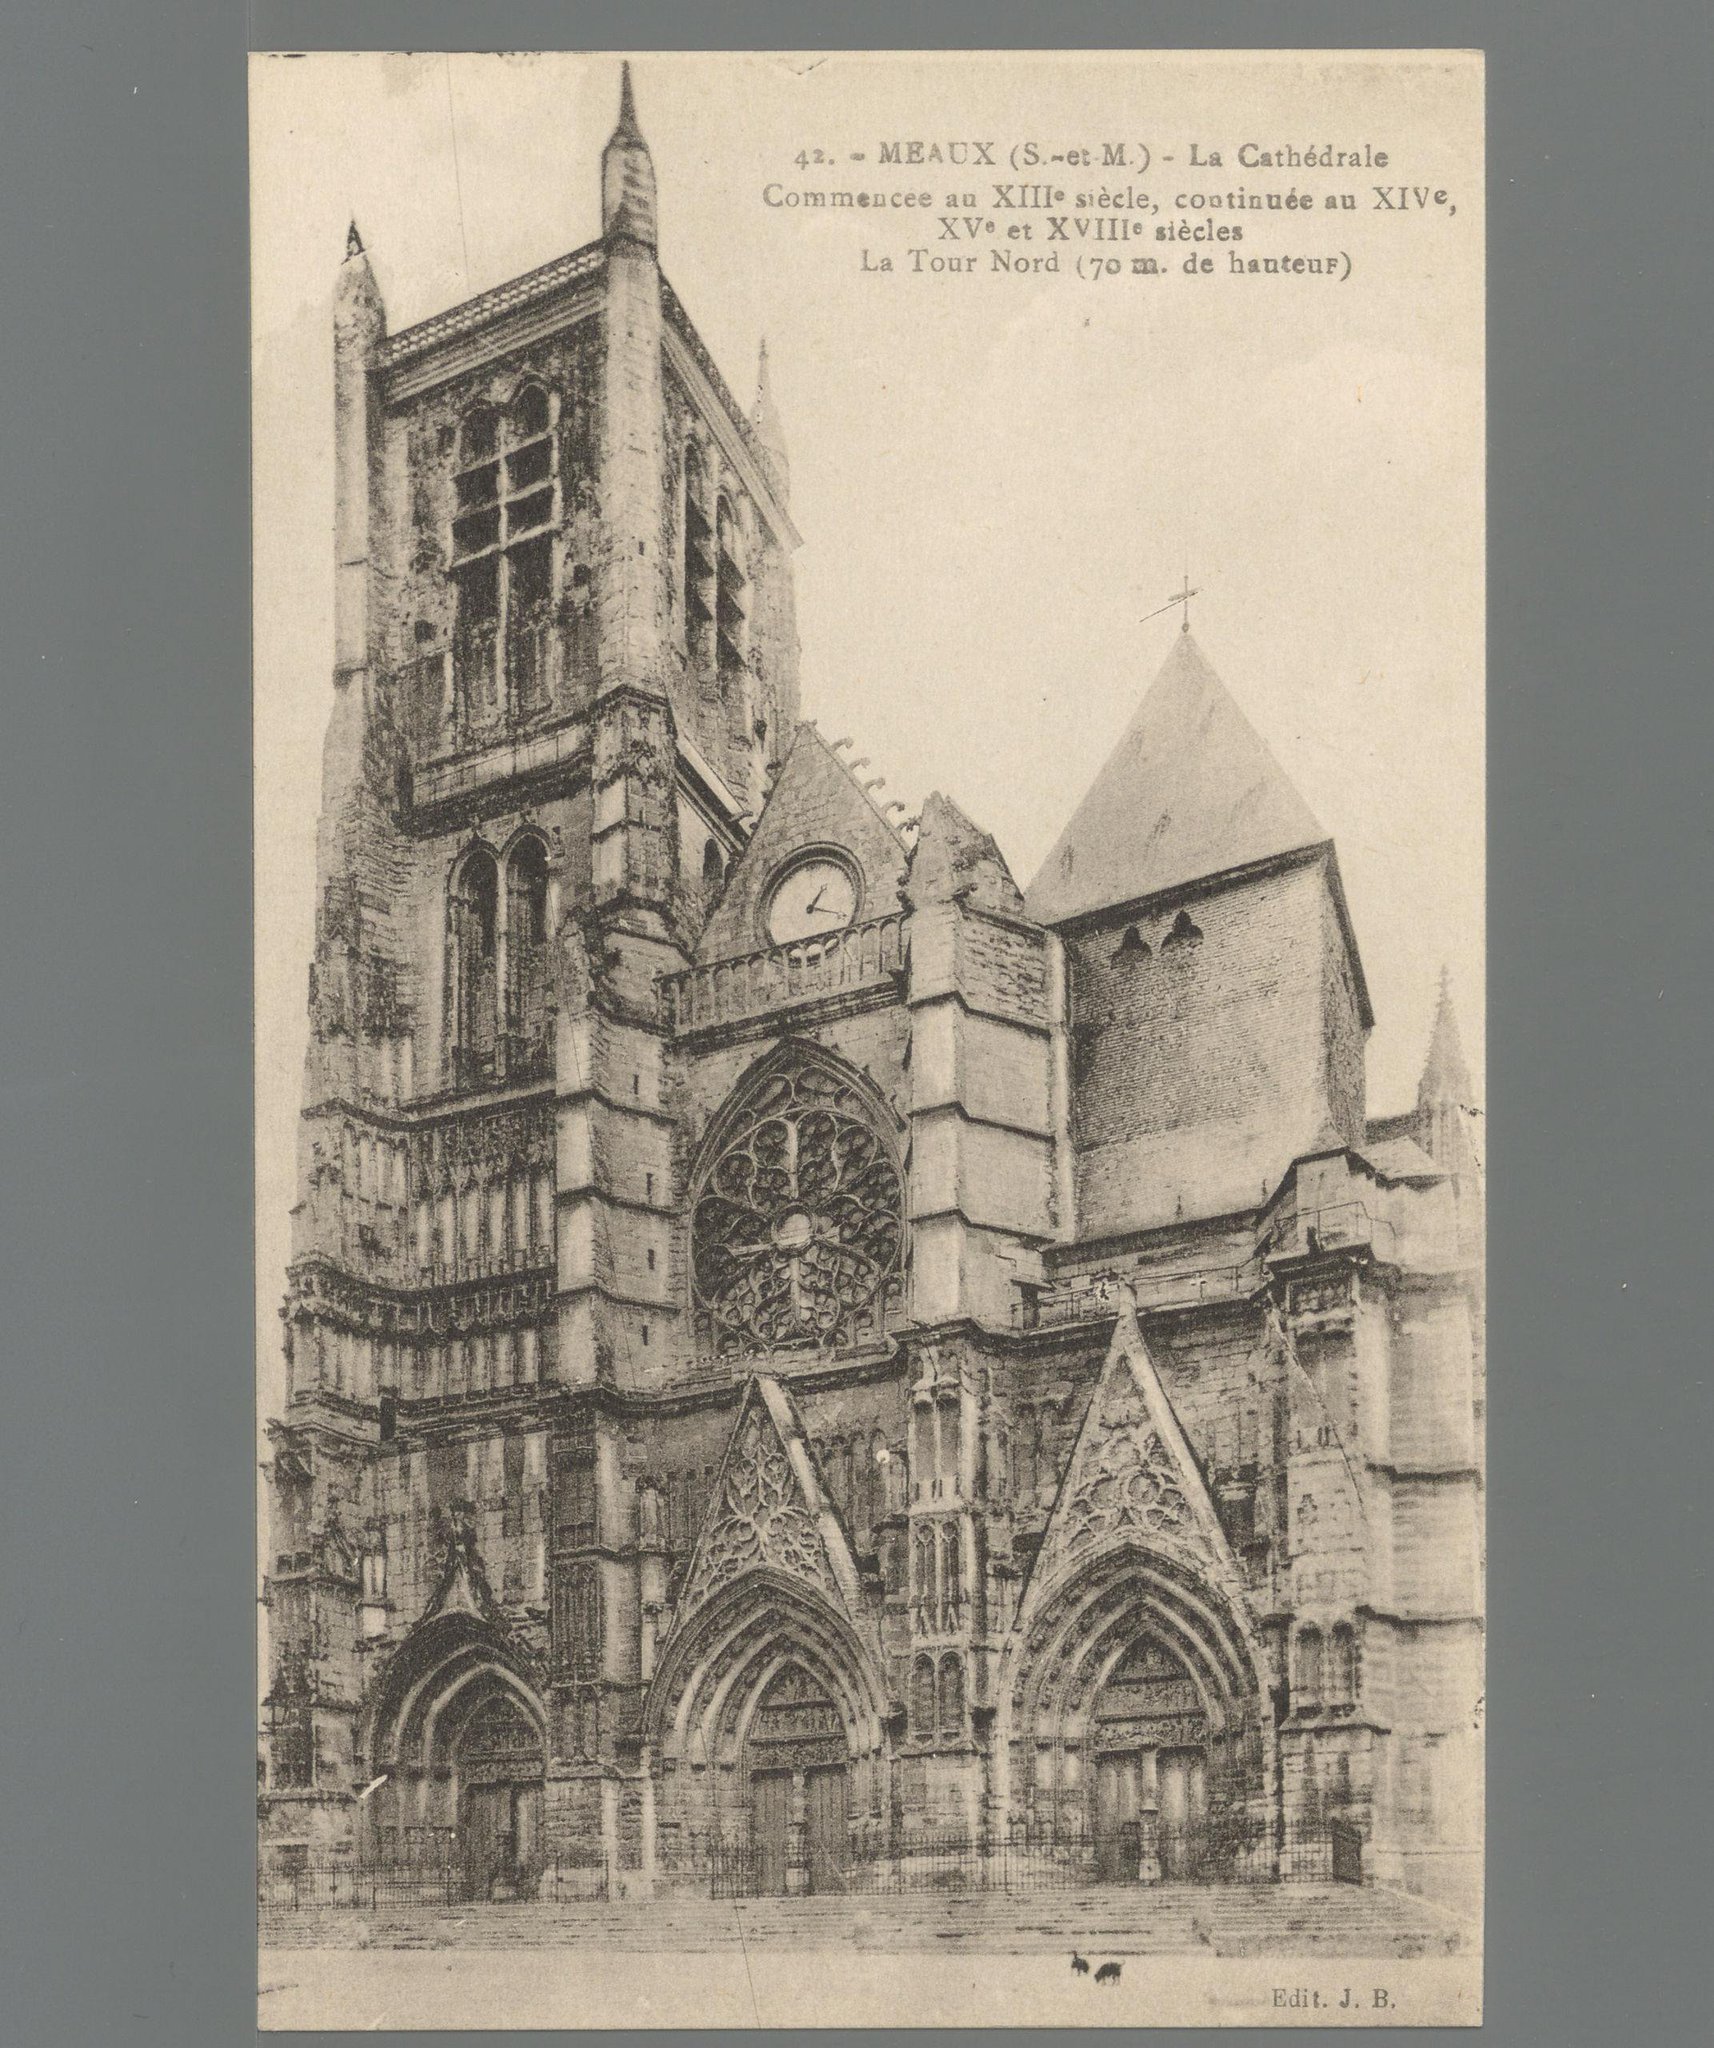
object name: photomechanical print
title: Meaux (S.-et-M.) - La Cathédrale. Commencee au XIIIe siècle, continuée au XIVe, XVe et XVIIIe siècles. La Tour Nord (70 m. de hauteur)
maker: Anonymous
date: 1903-1930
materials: cardboard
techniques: photograph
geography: château-thierry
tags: church (exterior)